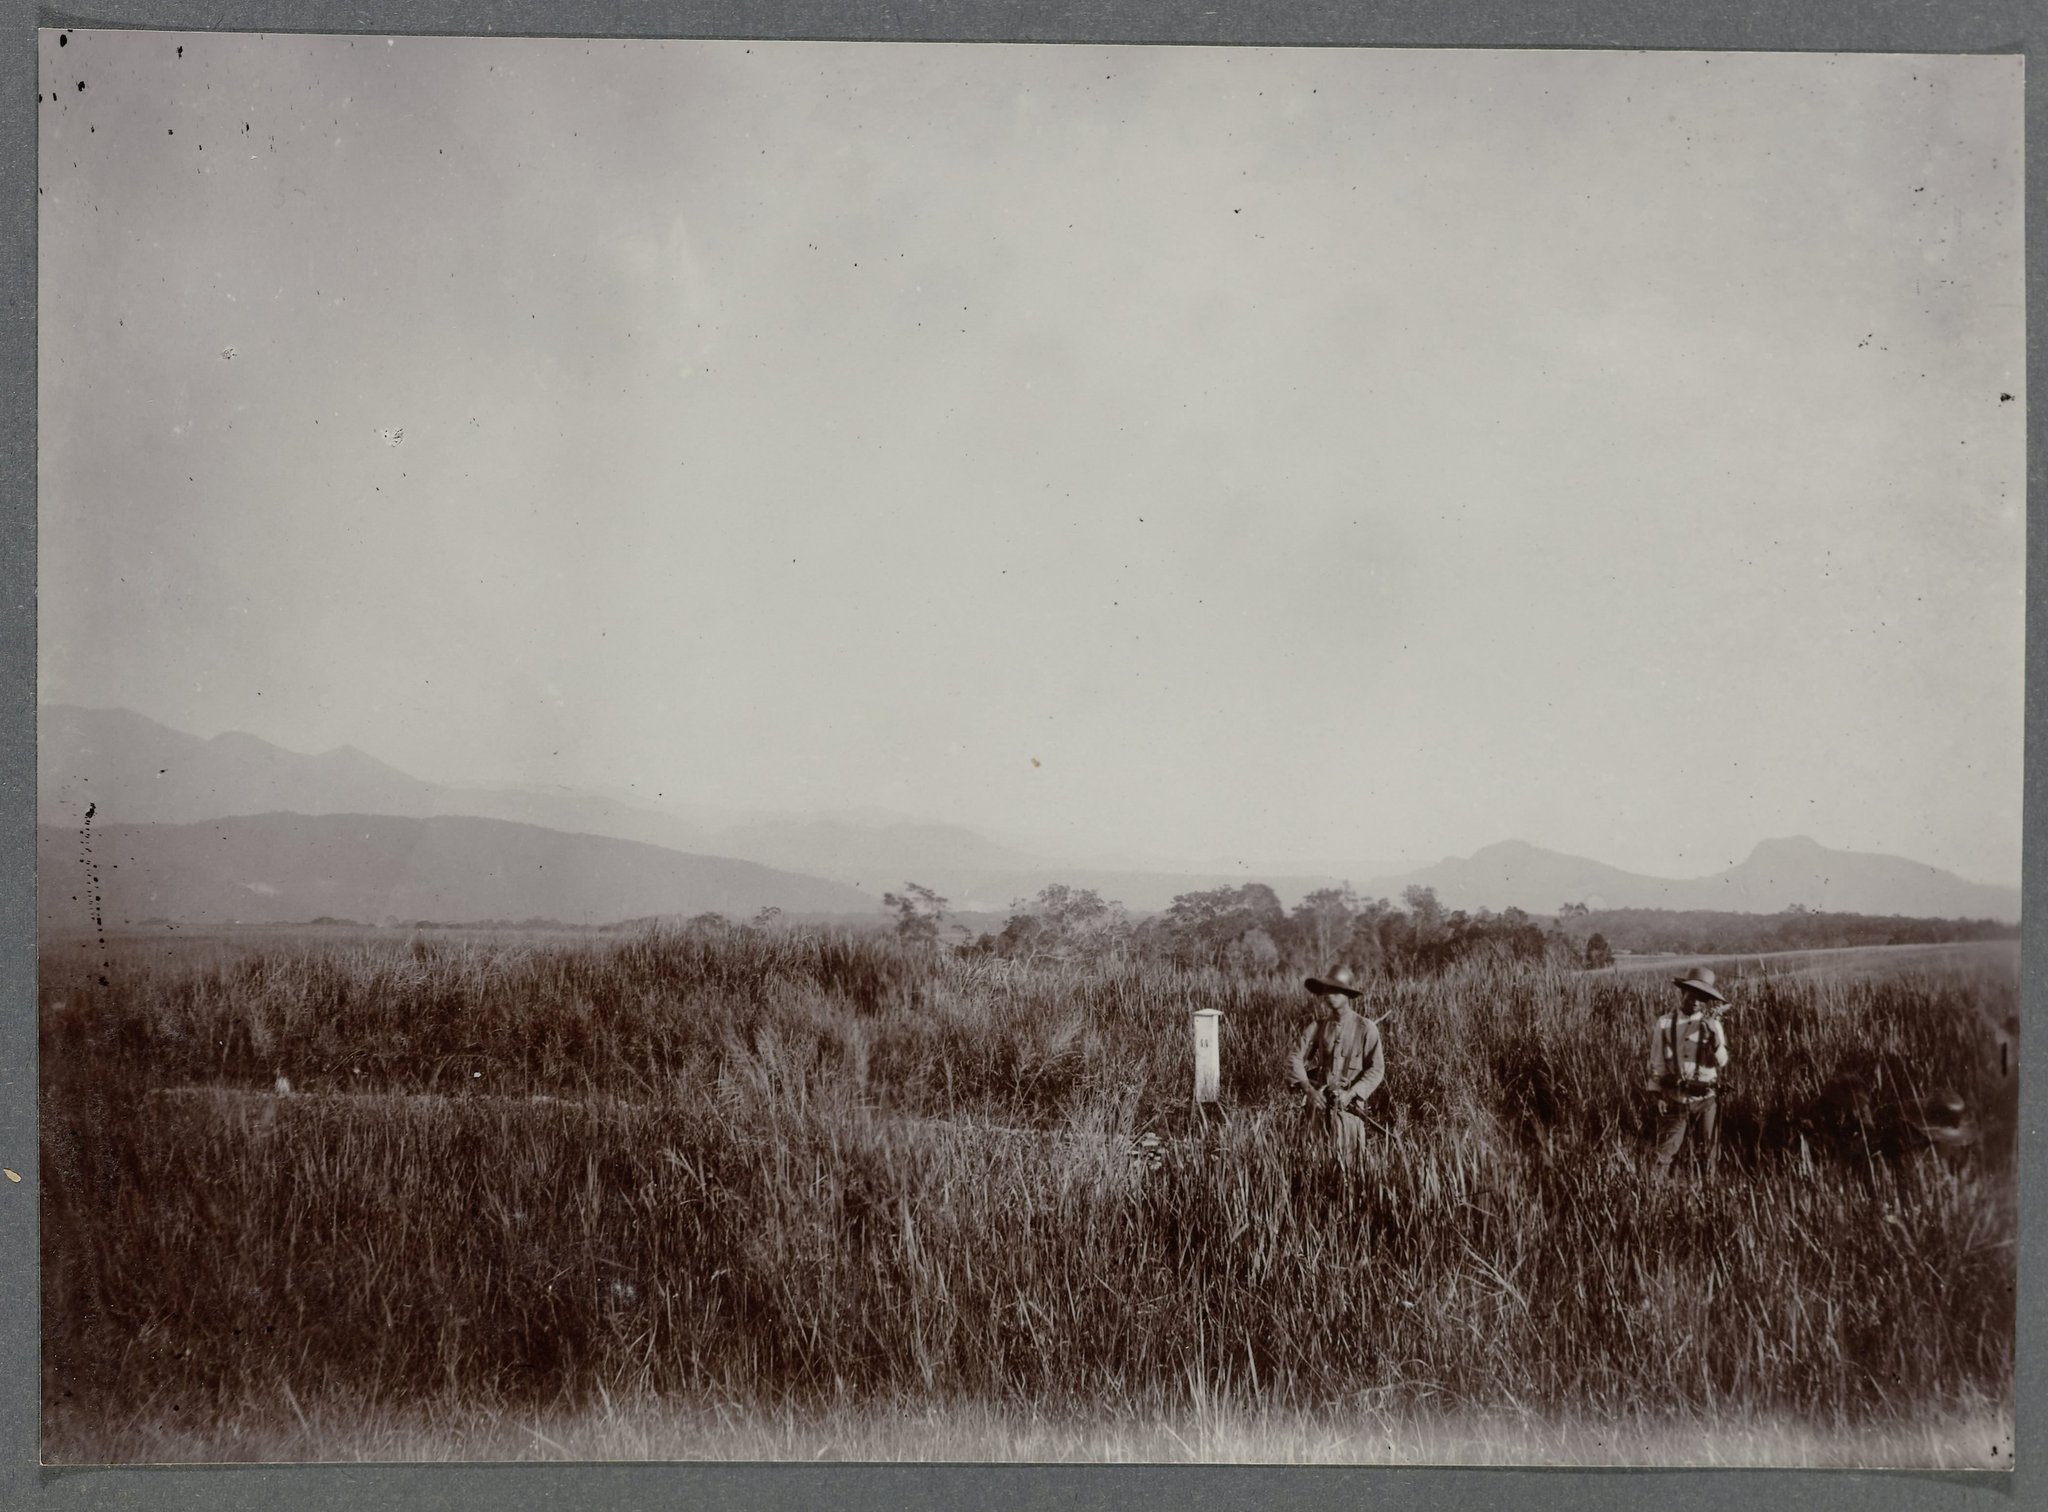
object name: photograph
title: Two Soldiers in the Field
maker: Anonymous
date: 1910-1913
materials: photographic support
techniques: gelatin silver print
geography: north sumatra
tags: arnhem, the hague, albertus dominicus laman trip, building activities, military service, traffic by road or path with motor-vehicle, landscapes in tropical and sub-tropical regions, road, path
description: Na de expedities naar de Gajo- en Alaslanden o.l.v. Van Daalen (eerste tocht in 1901), werd hij in 1903 belast met voorbereiding van permanente vestiging van Nederlands gezag. Aanleg van een weg van de Noordkust naar het binnenland was hierbij van groot belang. Deze zgn. Gajoweg werd aangelegd tussen 1903 en 1914, van Bireuen aan de kust naar Takinguen aan het bergmeer Danau Lauttawar, totale lengte 104 km.